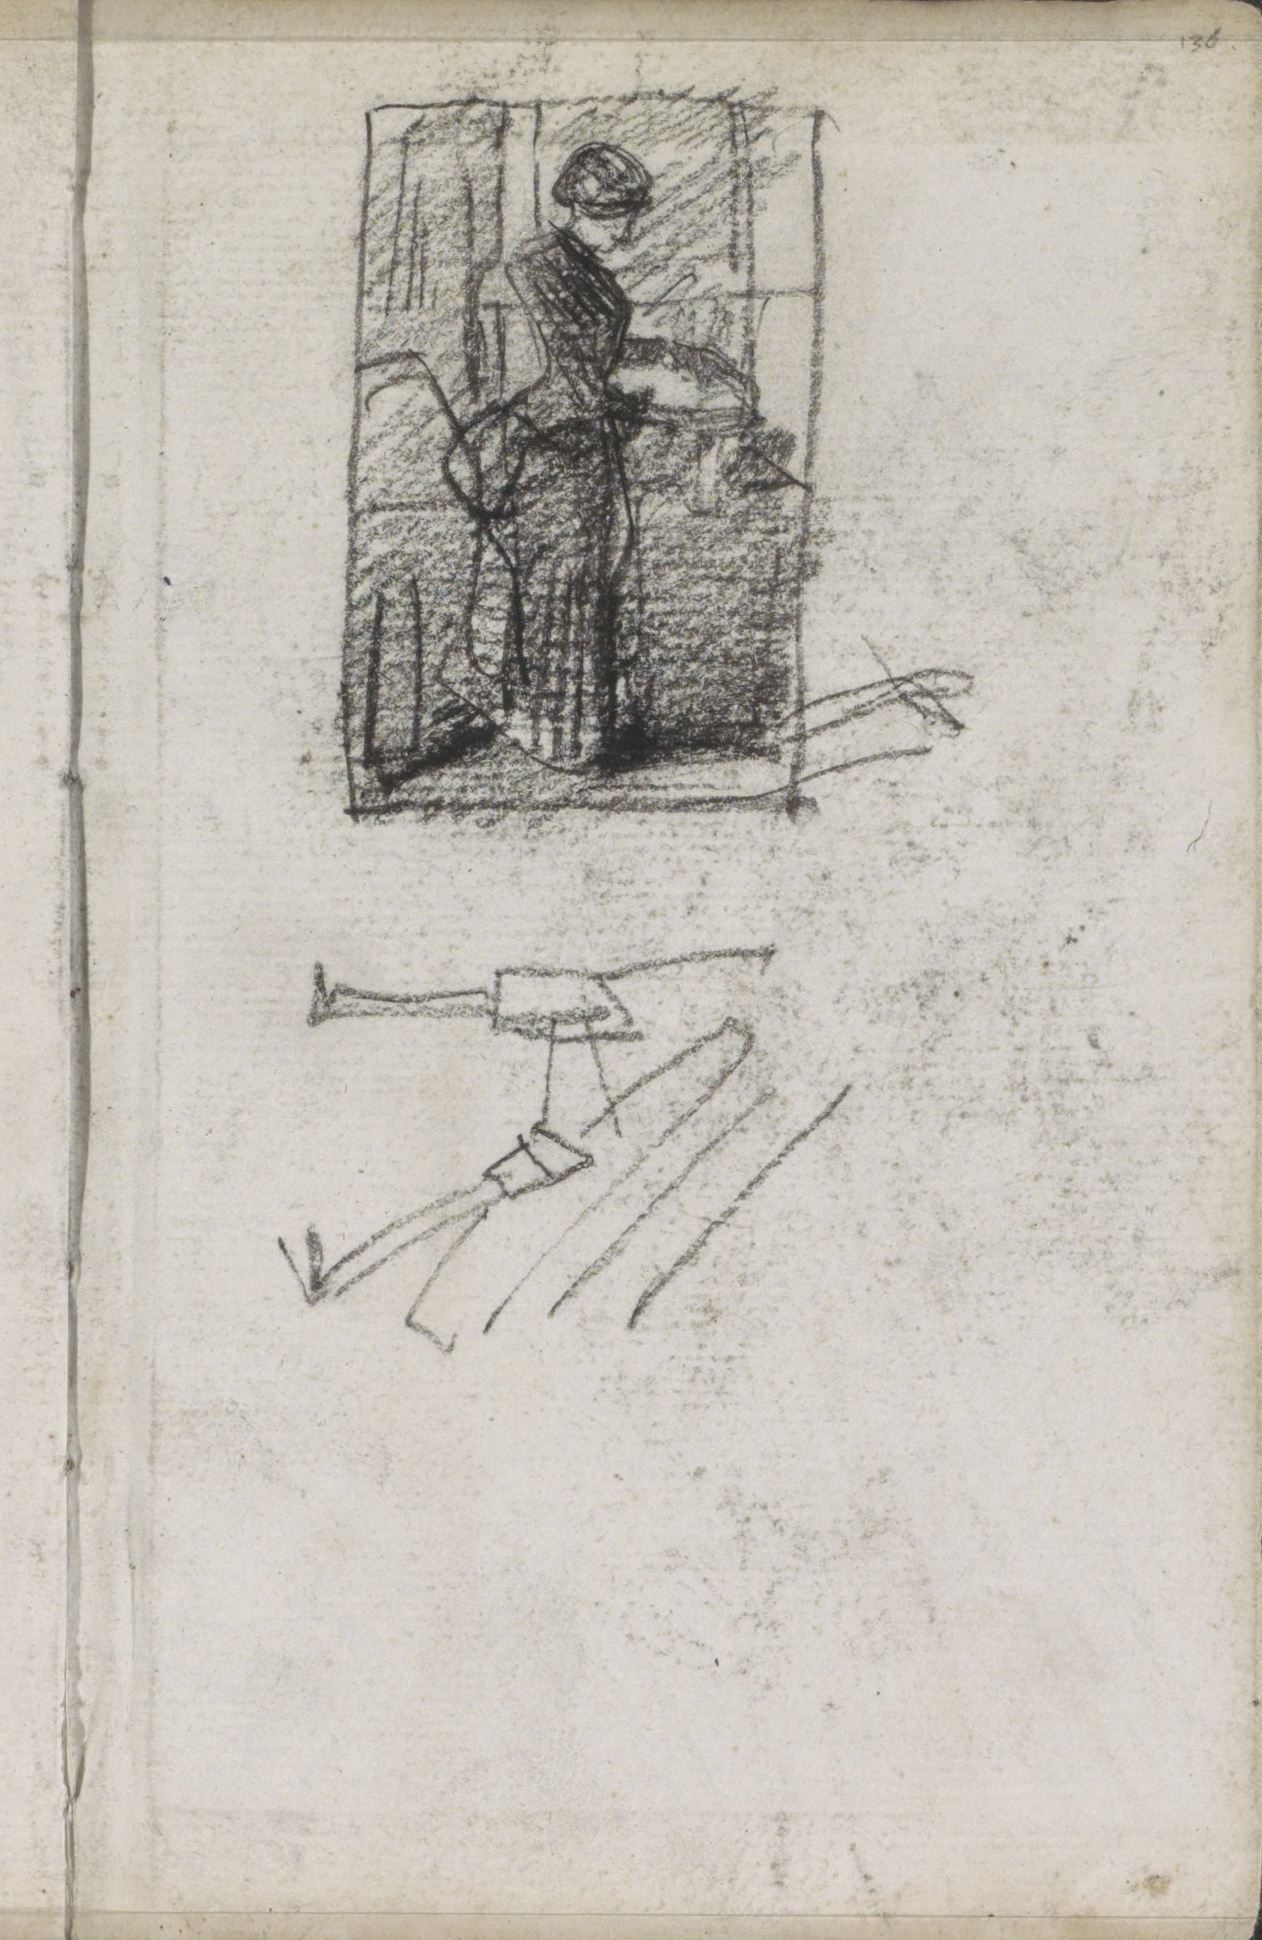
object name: sketchbook leaf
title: Staande vrouw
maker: george hendrik breitner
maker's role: draughtsman, painter, print maker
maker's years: 1857-1923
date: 1884-1886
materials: chalk, paper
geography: drenthe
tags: standing figure - aa - female human figure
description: Mogelijk een compositiestudie. Pagina 136, achterste schutblad, uit een schetsboek met 67 bladen vervaardigd in Drenthe.